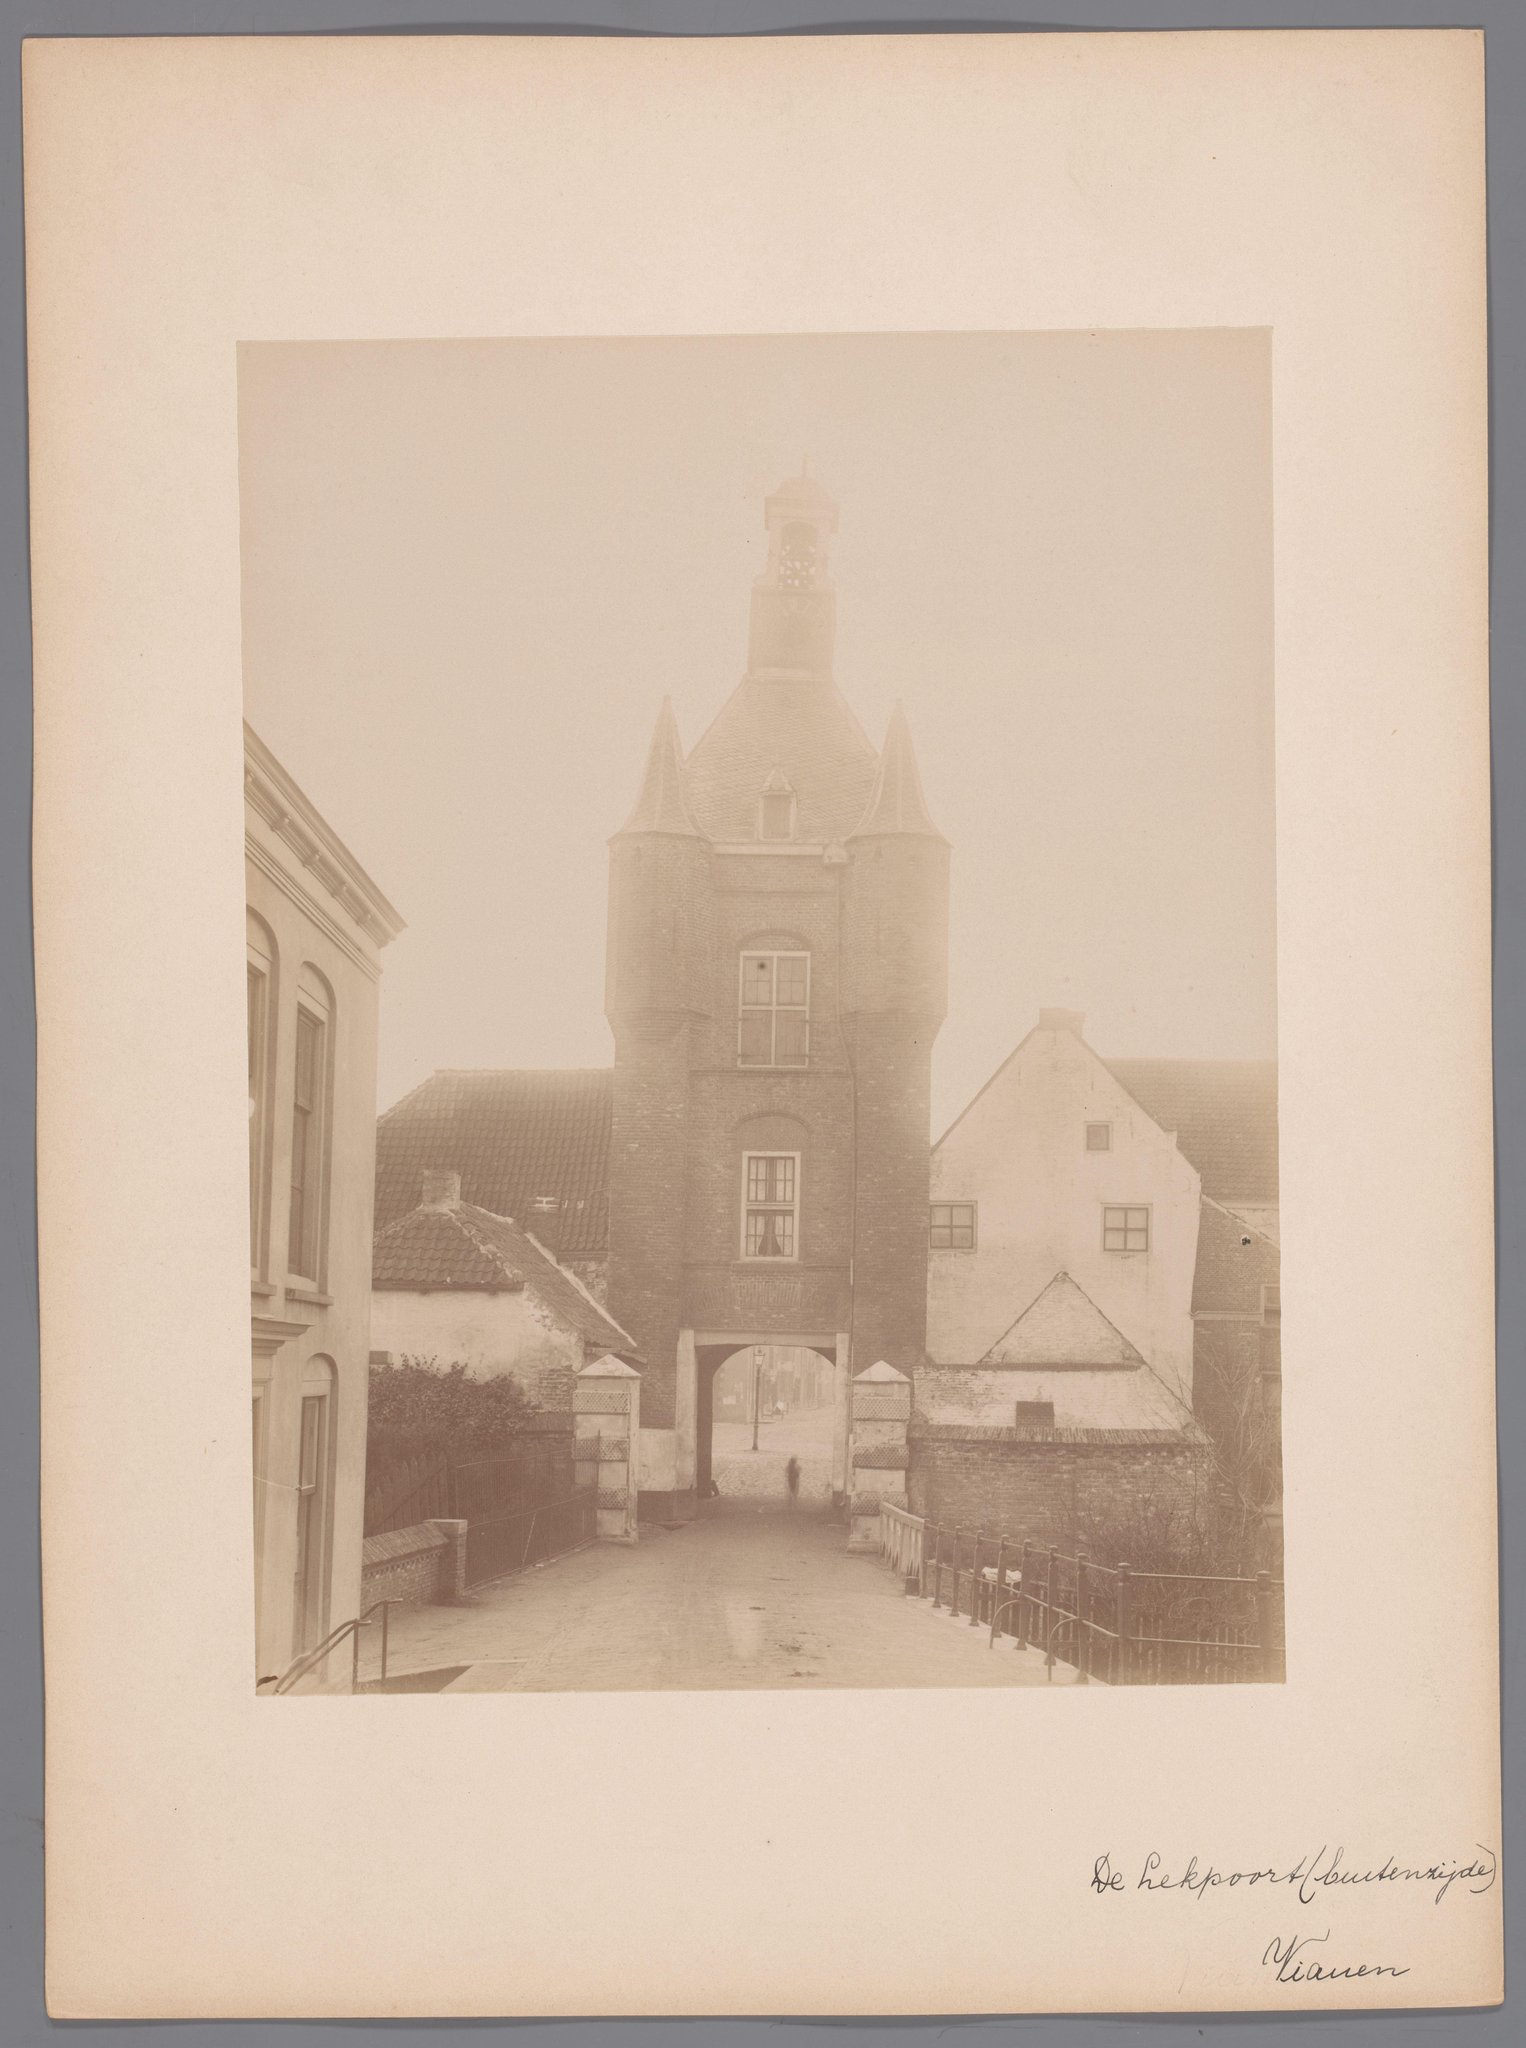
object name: photograph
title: Gezicht op de Lekpoort te Vianen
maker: anoniem (monumentenzorg)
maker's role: fotograaf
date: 1890-1920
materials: cardboard, photographic support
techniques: albumen print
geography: vianen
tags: gate, entrance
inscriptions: annotation: ‘De Lekpoort (buitenzijde)/ Vianen’, annotation: ‘Vianen/ Lekpoort (buiten)’